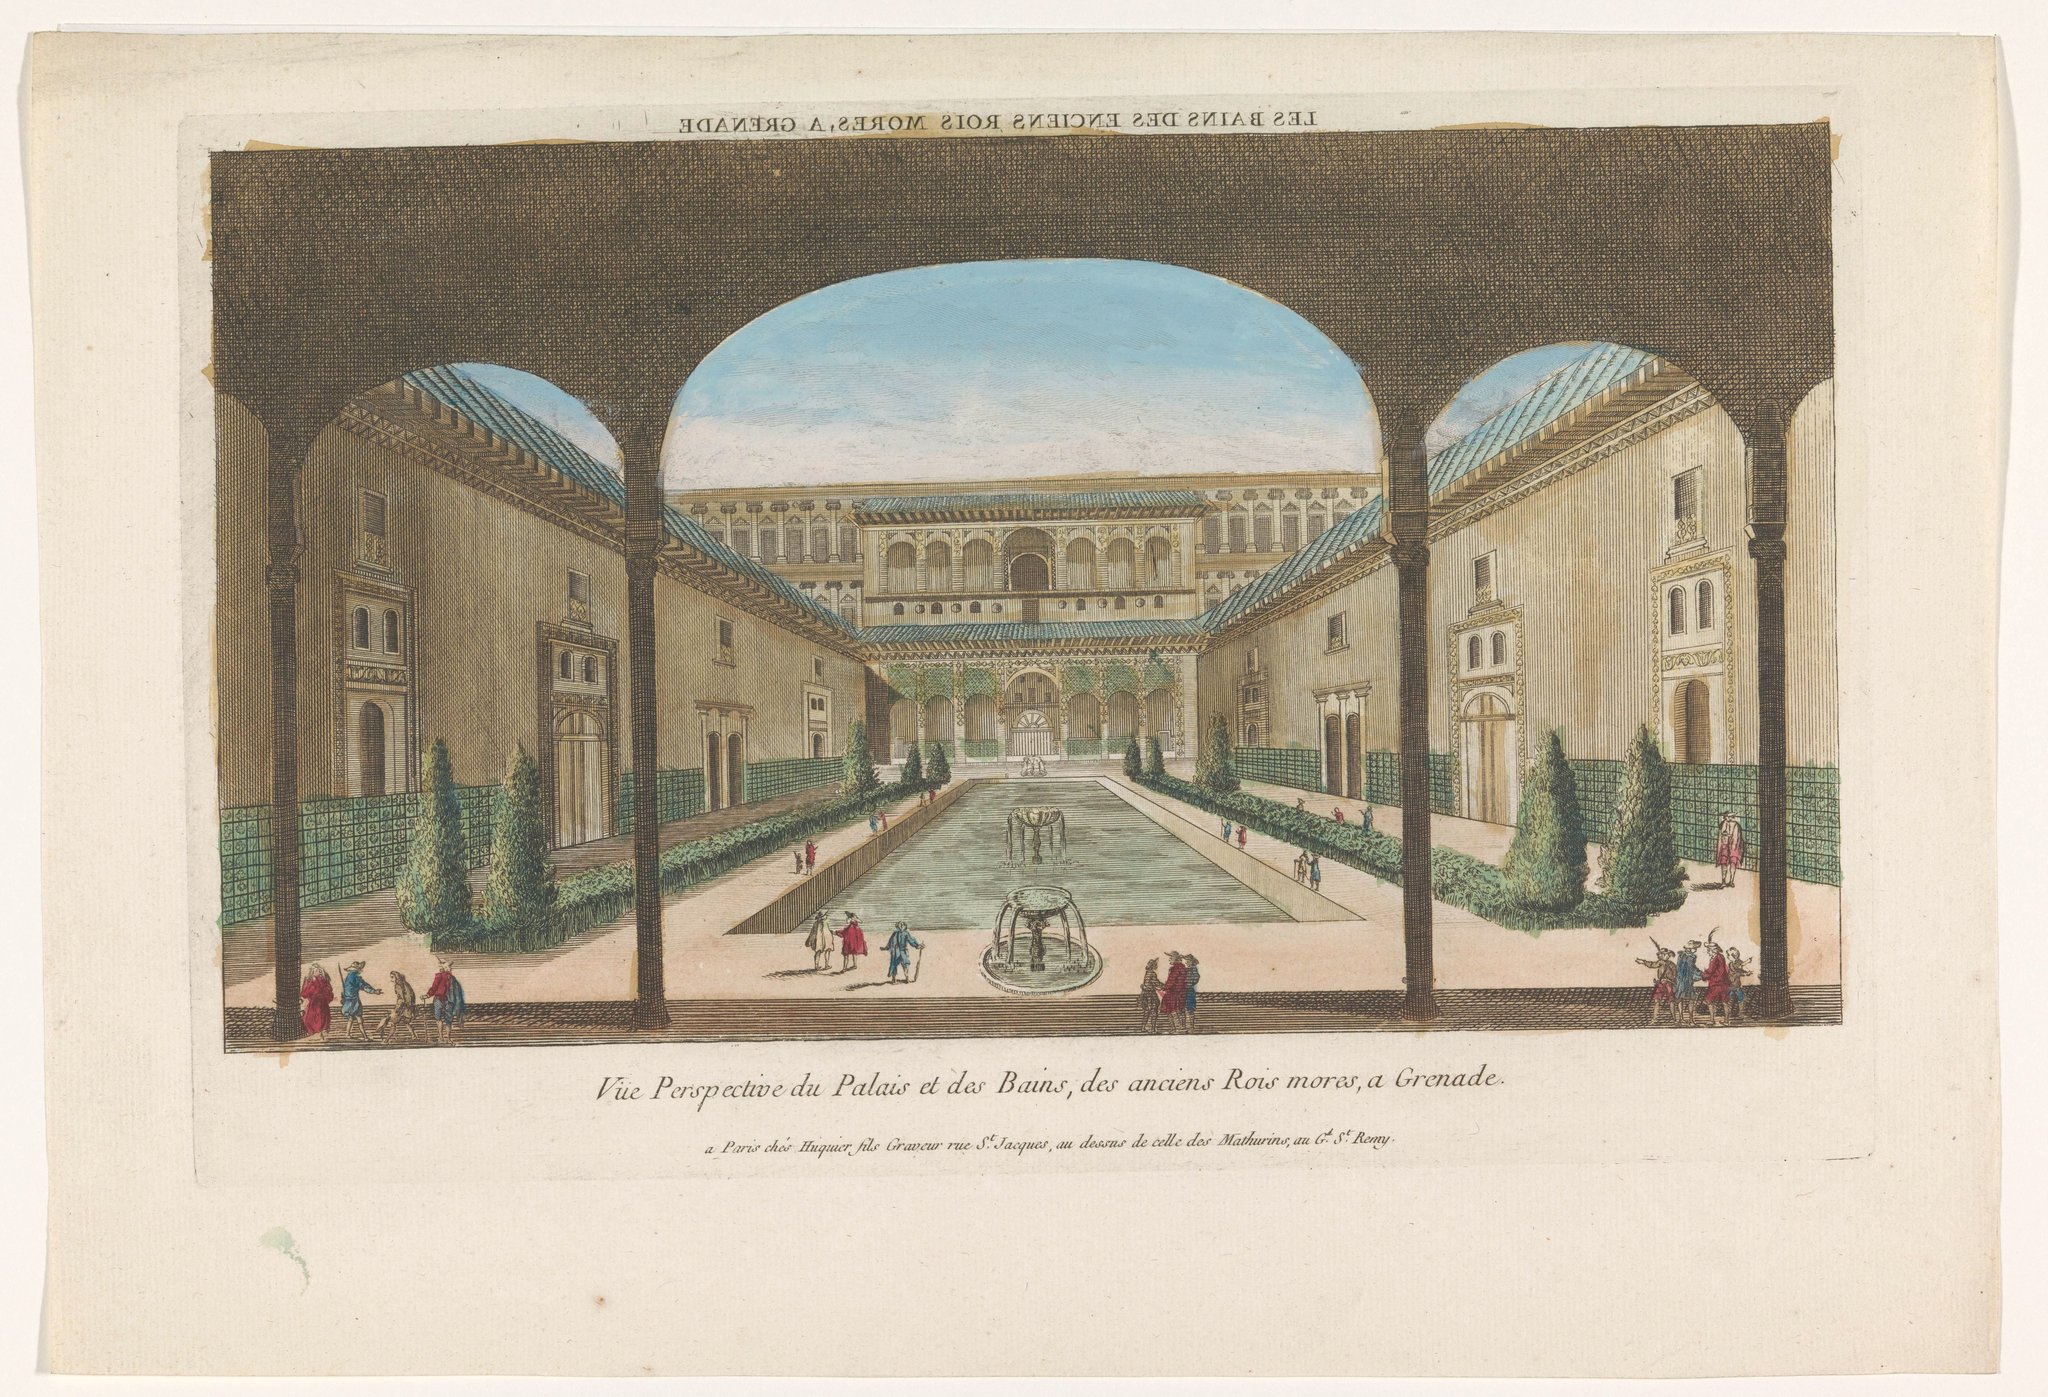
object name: opticaprent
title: Les bains des enciens rois Mores, a Grenade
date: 1735-1805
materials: paper, watercolor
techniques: brush, etching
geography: france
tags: palace, ornamental fountain, inner court of palace or 'hôtel'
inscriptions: watermark, collector's mark: Lugt 2233